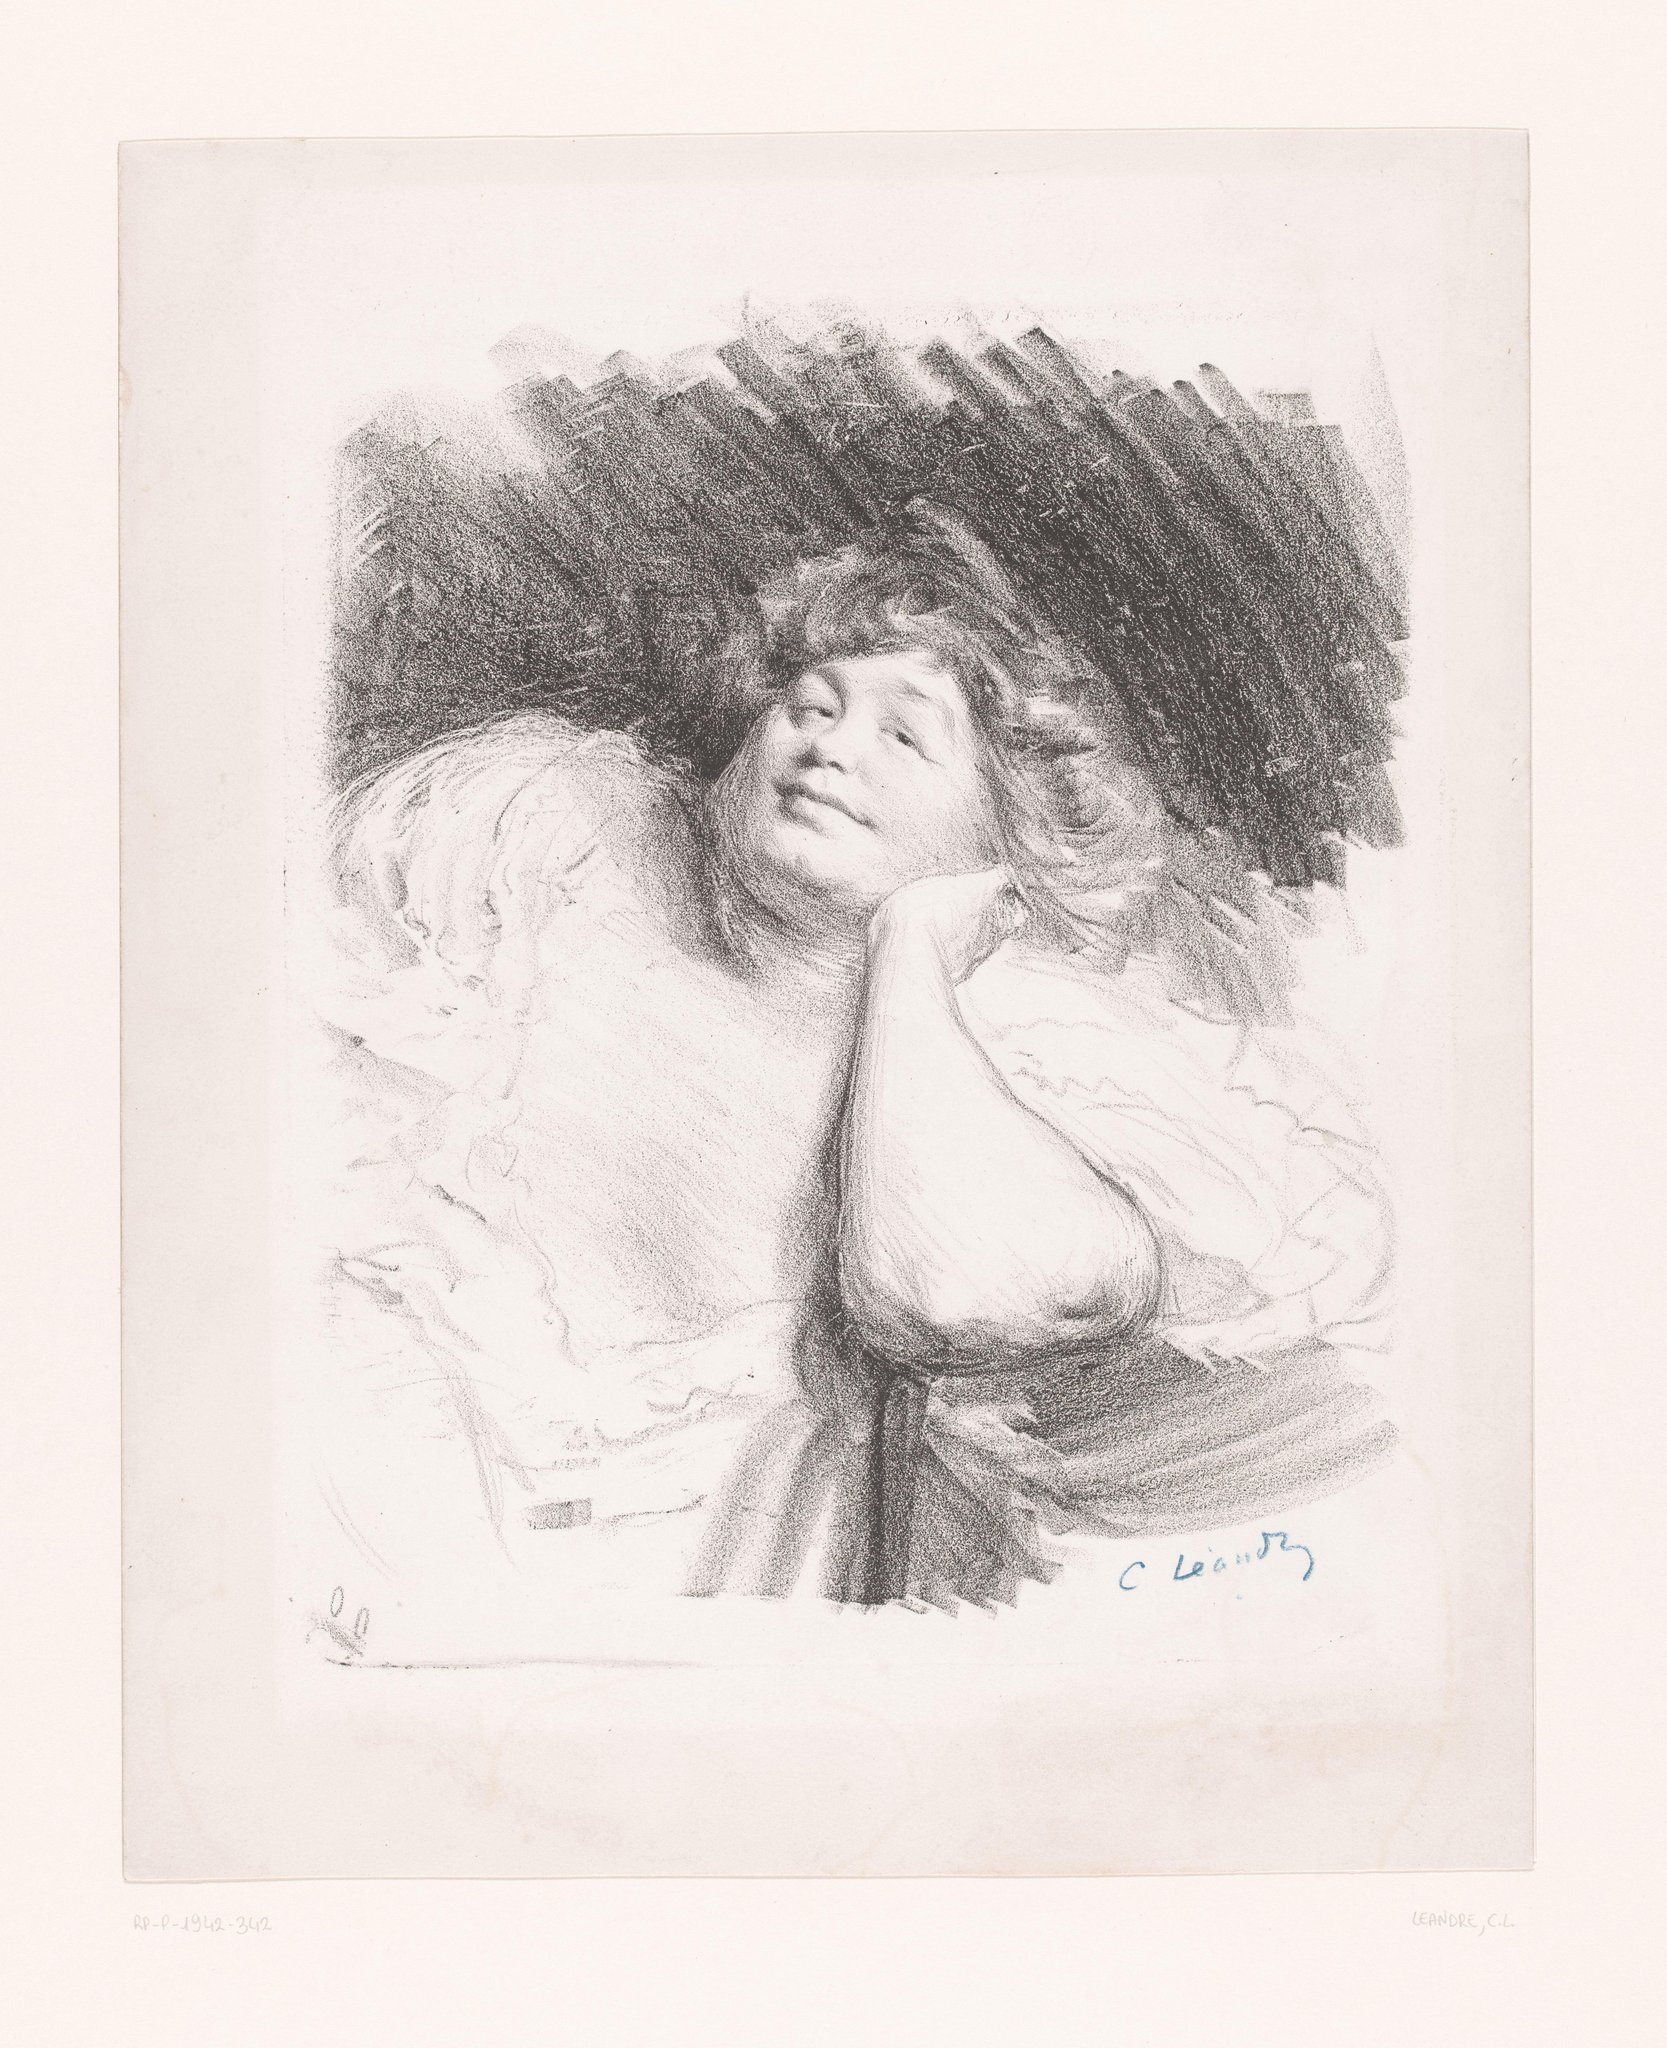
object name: print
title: Portret van een vrouw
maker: charles lucien léandre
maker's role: draughtsman, print maker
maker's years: 1862-1934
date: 1891-1934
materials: paper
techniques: lithography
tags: anonymous historical person portrayed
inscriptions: collector's mark: Lugt 2228a